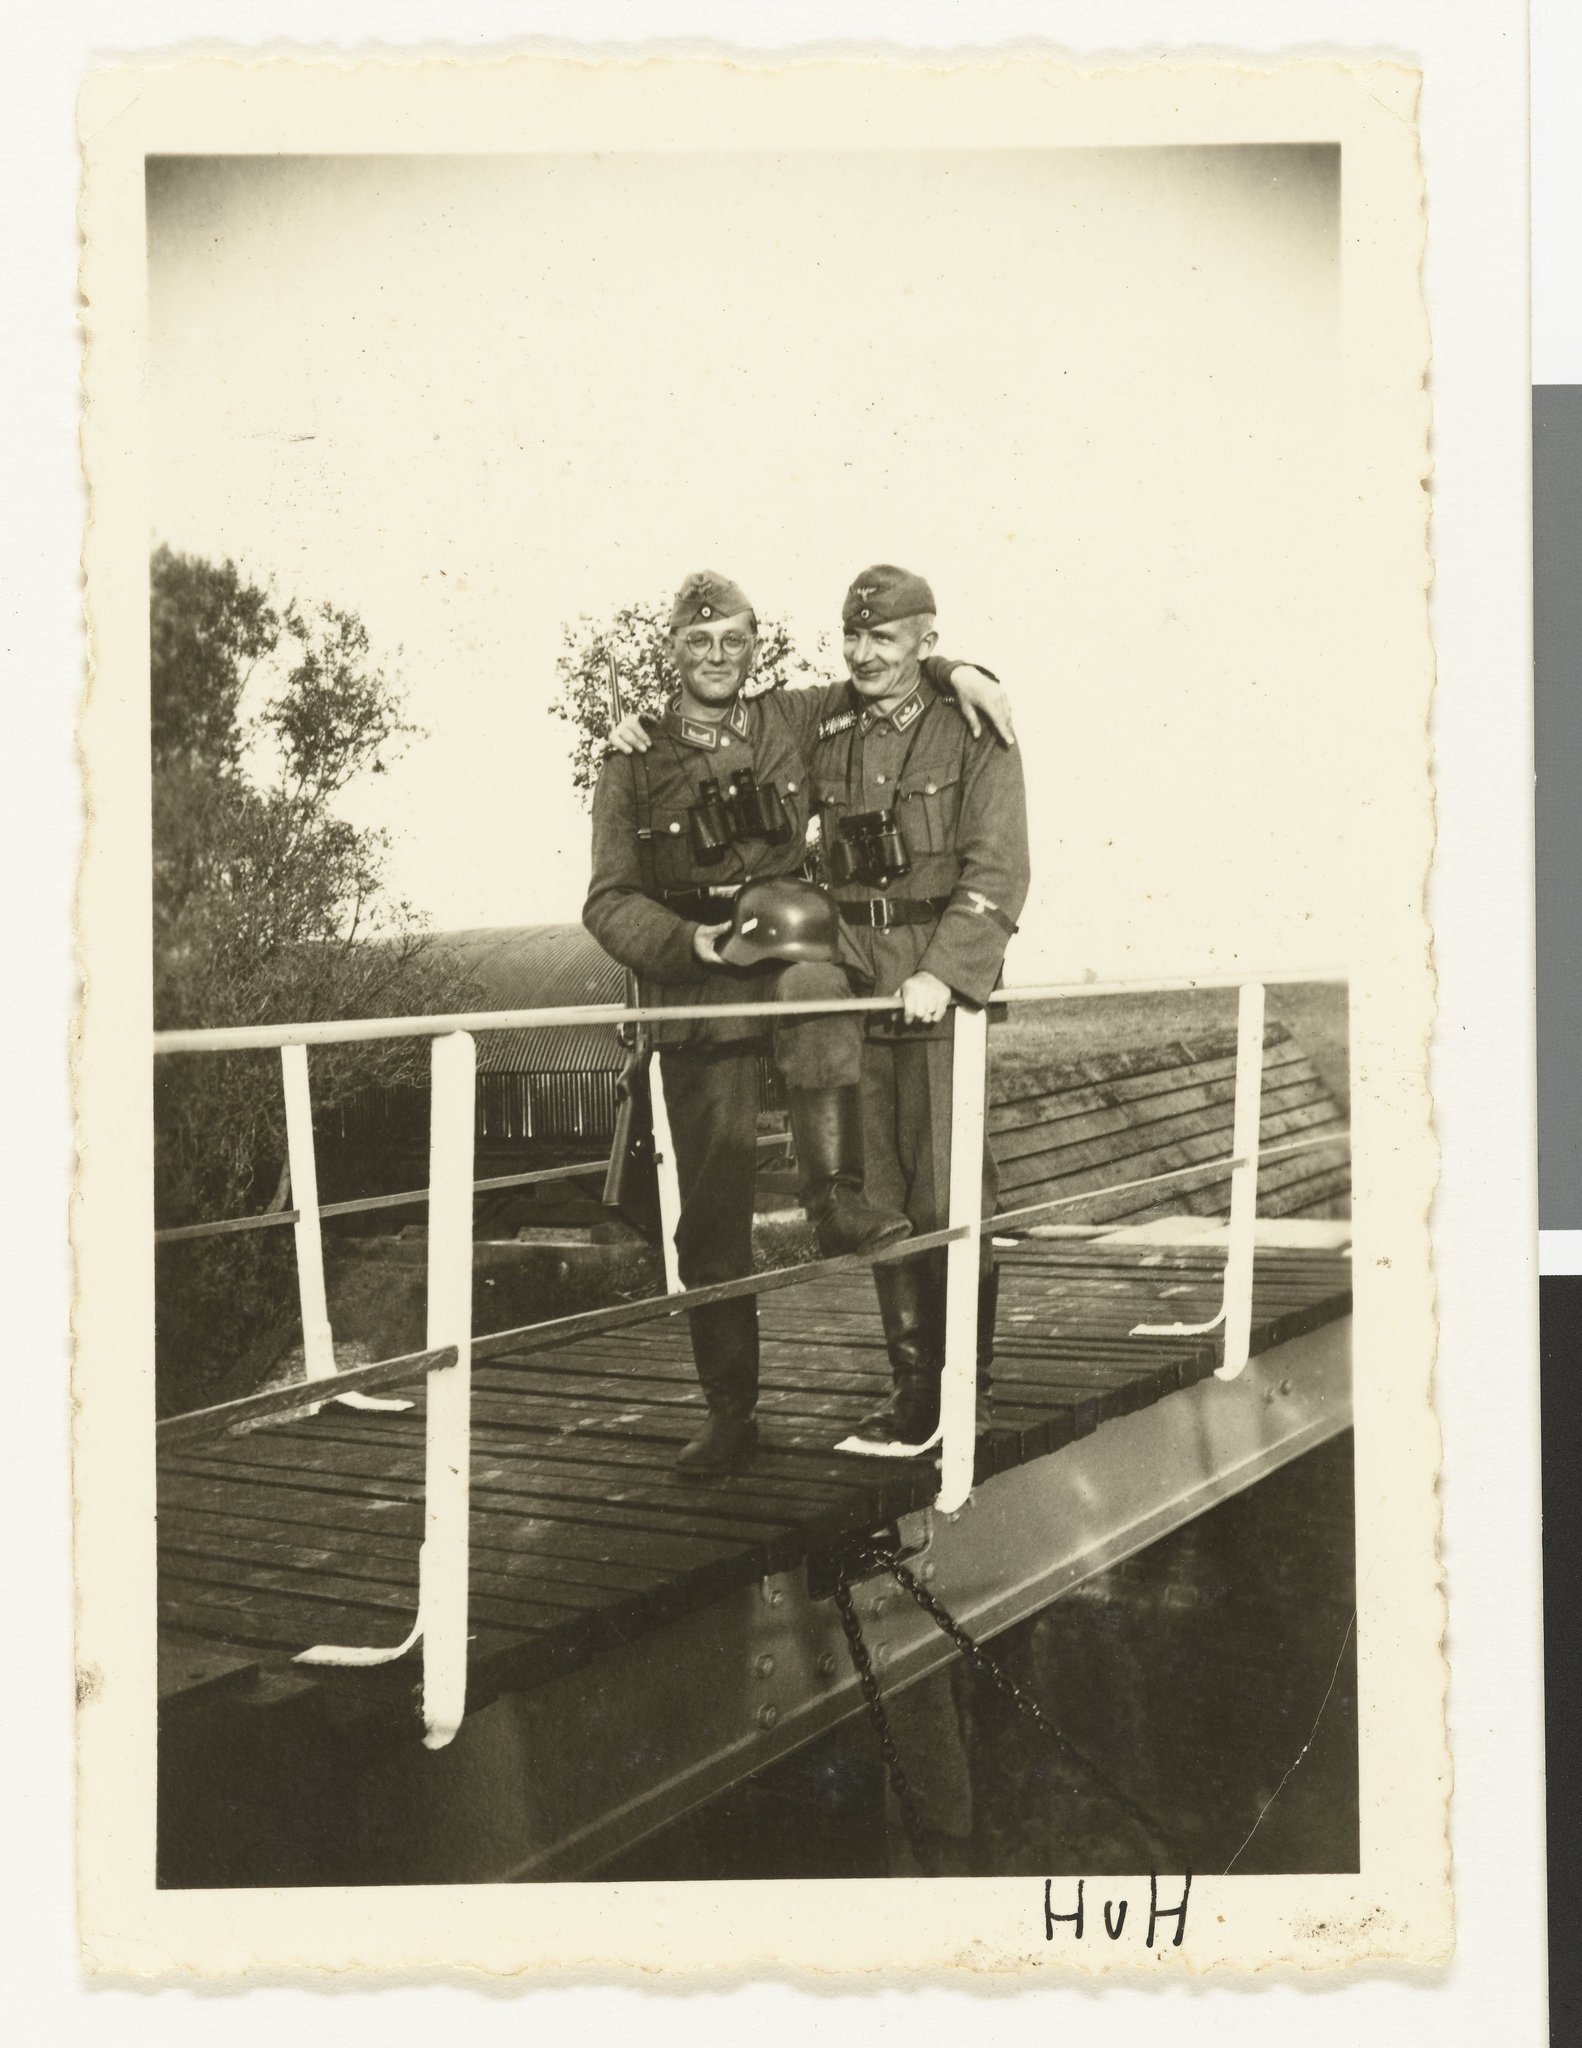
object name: photograph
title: Twee Wehrmacht soldaten op een bruggetje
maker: Anonymous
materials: photographic support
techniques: gelatin silver print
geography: hoek van holland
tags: the soldier; the soldier's life, occupation ~ war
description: Twee Wehrmacht soldaten hebben zich laten fotograferen op een bruggetje bij Hoek van Holland. Ze dragen legerpetten, maar een heeft ook nog een helm in zijn hand en draagt een bril. Beide hebben verrekijkers om.